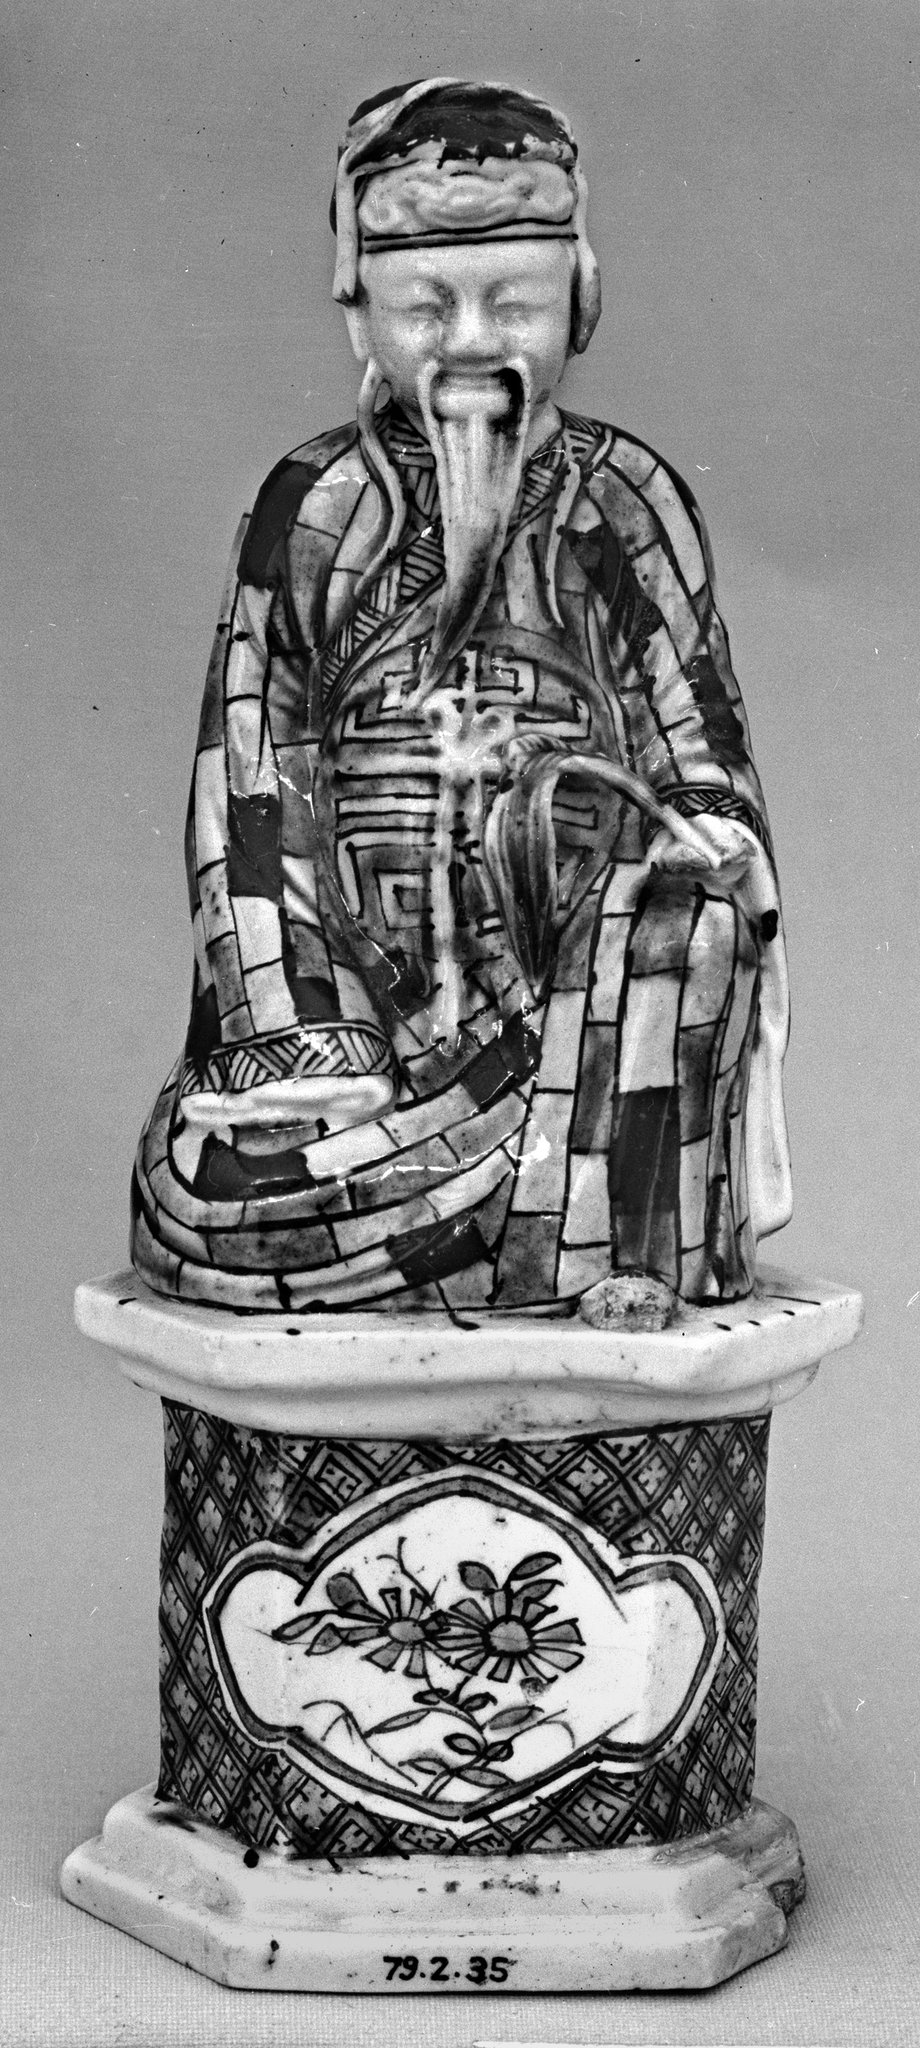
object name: figure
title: Figure of a seated immortal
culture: chinese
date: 1701-1733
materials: biscuit, enamel, porcelain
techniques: polychrome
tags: men